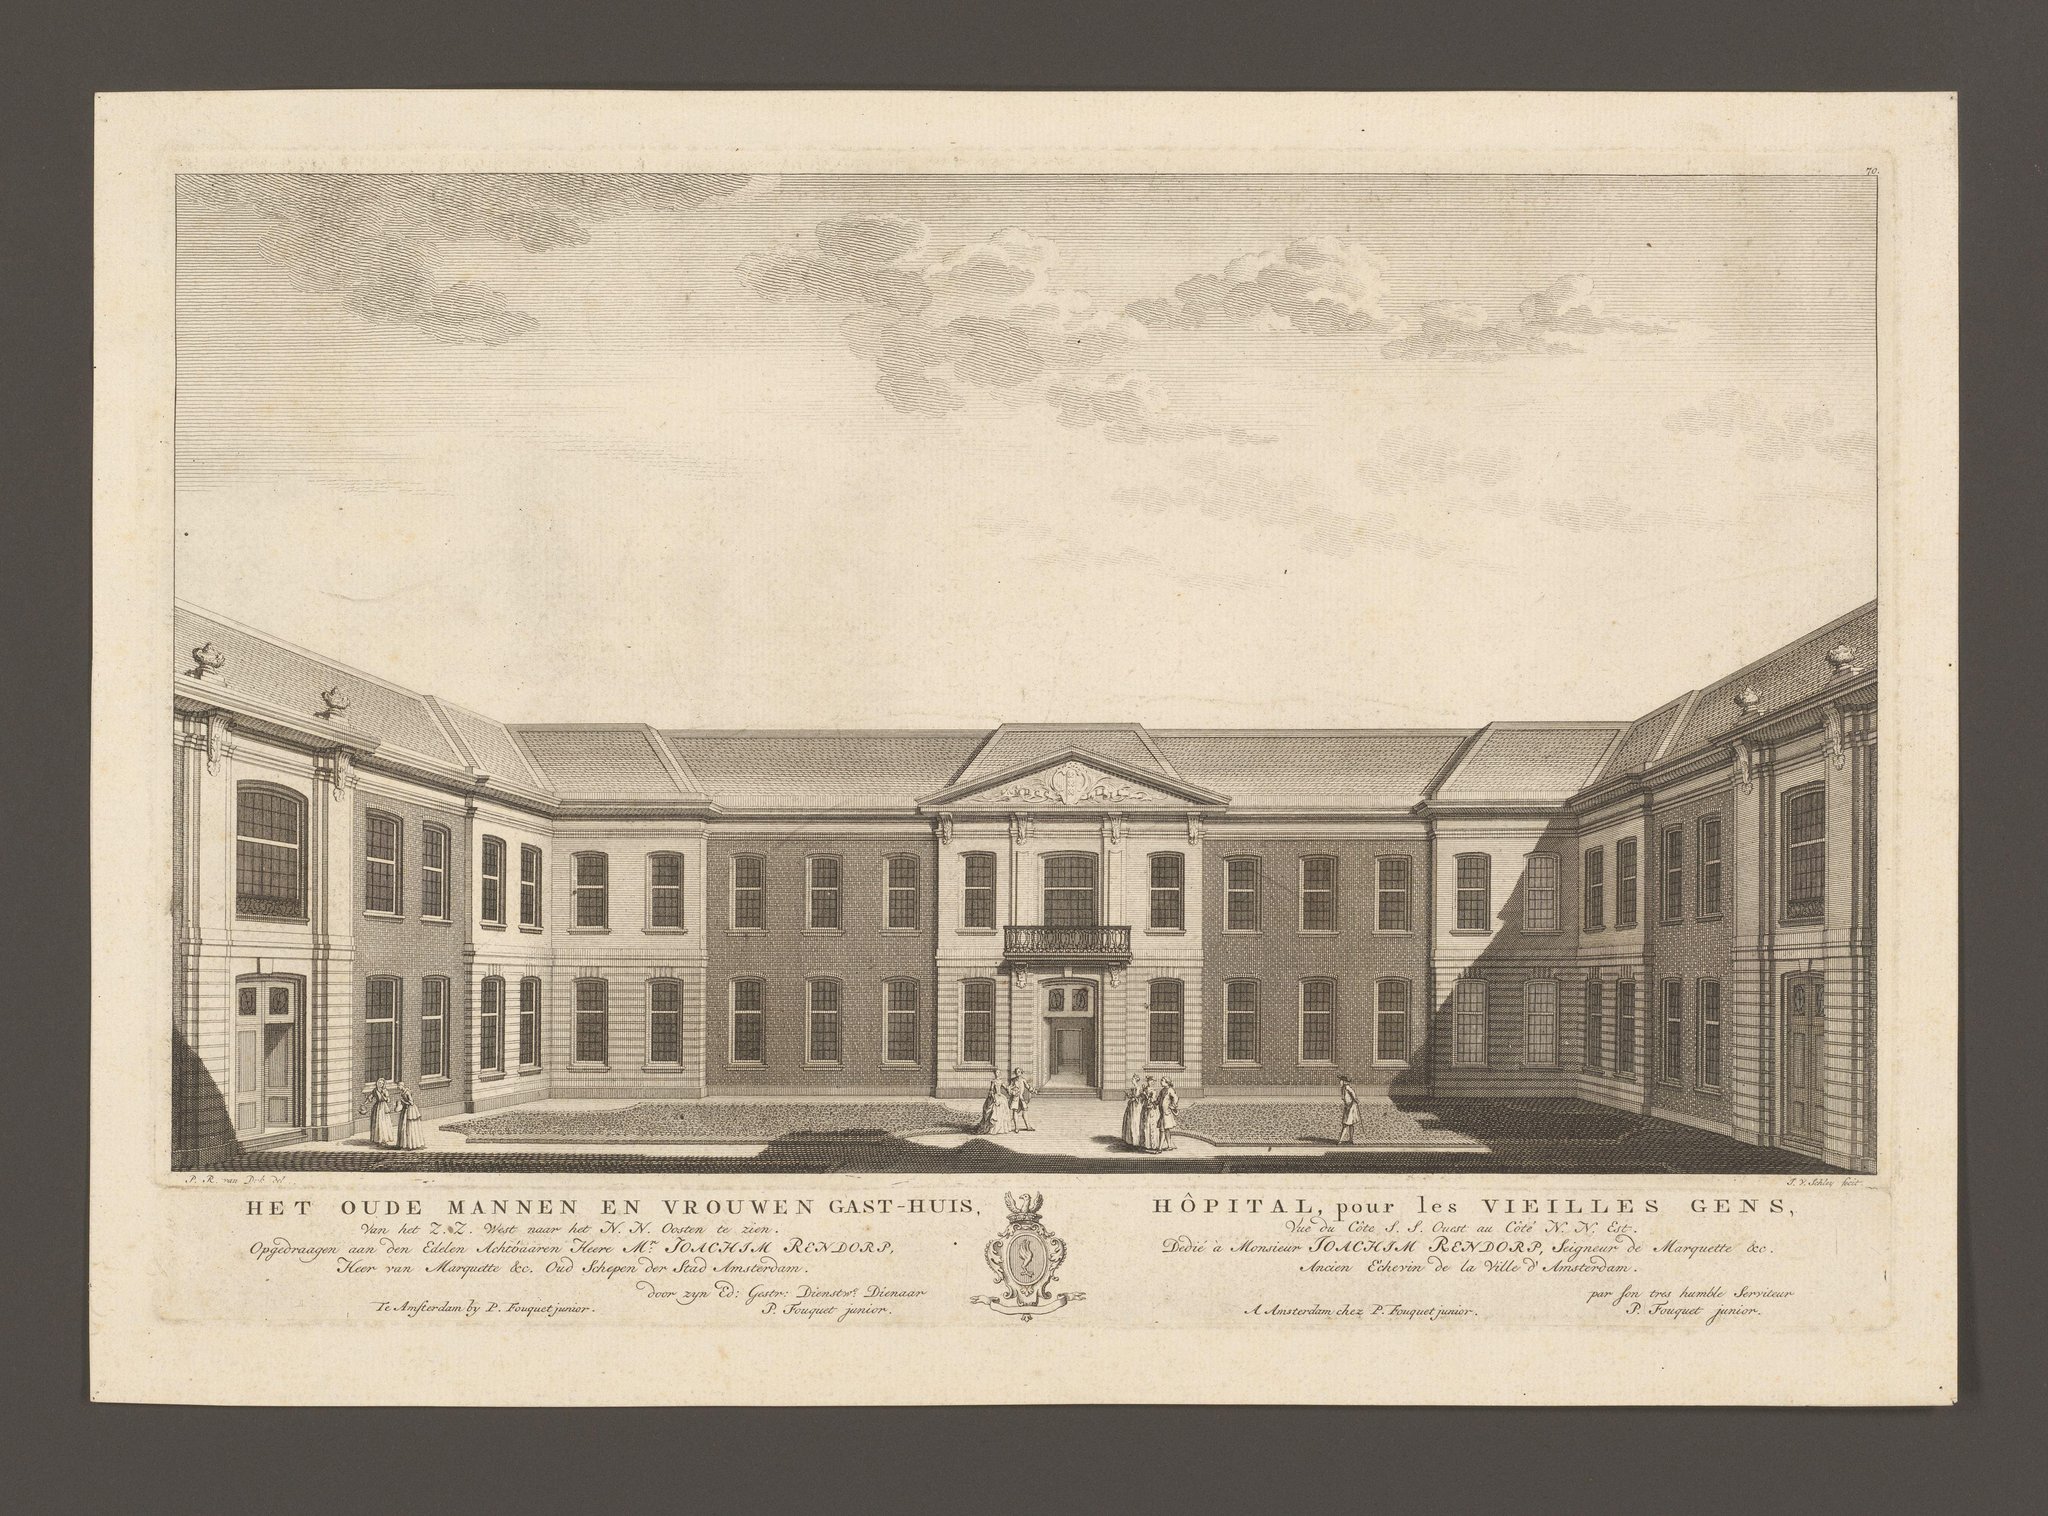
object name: print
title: Het Oude Mannen en Vrouwen Gast-Huis van het Z.Z. West naar het N.N. Oosten te zien / Hôpital, pour les Vieilles Gens, vue du côté S.S. Ouest au côté N.N. Est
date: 1760-1783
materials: paper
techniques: engraving, etching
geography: amsterdam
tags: public welfare, poorhouse, courtyard, armorial bearing, heraldry, old-people's home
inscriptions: collector's mark: ‘Historische commissie der universite [...]’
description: Deze prent is ook gebruikt in de zogenaamde Atlas van Fouquet.* Pierre Fouquet gaf vanaf 1760 stadsgezichten van Amsterdam - naar tekeningen van verschillende kunstenaars, gemaakt door verschillende prentmakers - uit. Deze prenten werden aanvankelijk los of in series verkocht. Zoals toen gebruikelijk kon de koper de prenten zelf laten inbinden. Hiertoe gaf Fouquet tussen 1778 en 1783 een titelblad, plattegrond en inhoudsopgave van de tot dusver 100 uitgegeven prenten uit (1). Gezien de inhoud afhankelijk was van wat de koper had verzameld verschilt de inhoud van de verschillende bewaarde Fouquetatlassen onder deze titel sterk. Ook zijn er exemplaren bekend waar tevens andere prenten aan zijn toegevoegd. Omdat er behoefte bleek aan uitleg bij de platen werd in 1783 een nieuwe versie van de atlas uitgegeven, aangevuld met tekst en twee prenten. De aangegeven volgorde veranderde maar de platen van de al eerder uitgegeven prenten bleven ongewijzigd. Deze uitgave werd in opdracht van Fouquet gedrukt bij Daniël Jean Changuion en Petrus den Hengst (2). Een tiental platen werd bijgewerkt en verscheen, met nieuw impressum, in het vervolg van Wagenaars geschiedenis van Amsterdam, uitgeven door Petrus Conradi en Folkert van der Plaats (3). Een aantal jaar na het overlijden van Fouquet kwam Evert Maaskamp met een nieuwe uitgave van de atlas, met verbeterde tekst en toevoeging van twee prenten. Op alle platen verwijderde hij het oude en liet hij zijn eigen impressum zetten (4). De huidige staat van de prent komt voor in exemplaren van de onder (1) en (2) genoemde werken. * Onder de Atlas van Fouquet of Fouquetatlas verstaan we de hieronder vermelde publicaties (1), (2) en (4). (1). Afbeeldingen van de wyd-vermaarde koopstad Amsterdam benevens des zelvs voornaamste gebouwen en gezigten alle naar het leeven getekend / Receuil des edifices les plus considerables et des plus belles vues, de la fameuse ville d'Amsterdam, dessinées d'après nature. Amsterdam: Pierre Fouquet, 1778-1783. (2). Nieuwe atlas, van de voornaamste gebouwen en gezigten der stad Amsterdam, met derzelver beknopte beschryvingen. 2 dln. Amsterdam: Daniël Jean Changuion en Petrus den Hengst [in opdracht van Pierre Fouquet], 1783. (3). Stijl, Simon. Amsterdam, in zyne geschiedenissen, voorregten, koophandel, gebouwen, kerkenstaat, schoolen, schutterye, gilden en regeeringe, beschreeven. Om te dienen ten vervolge op het werk van Jan Wagenaar (…). 10 dln. Amsterdam en Harlingen: Petrus Conradi en Folkert van der Plaats, 1788-1801. (4). Nieuwe atlas, van de voornaamste gebouwen en gezigten der stad Amsterdam. Met derzelver beknopte beschryvingen. Amsterdam: Evert Maaskamp, 1805. * Het aantal vermelde staten is gebaseerd op het aantal gevonden staten. Mogelijk zijn er meer staten van deze prent.